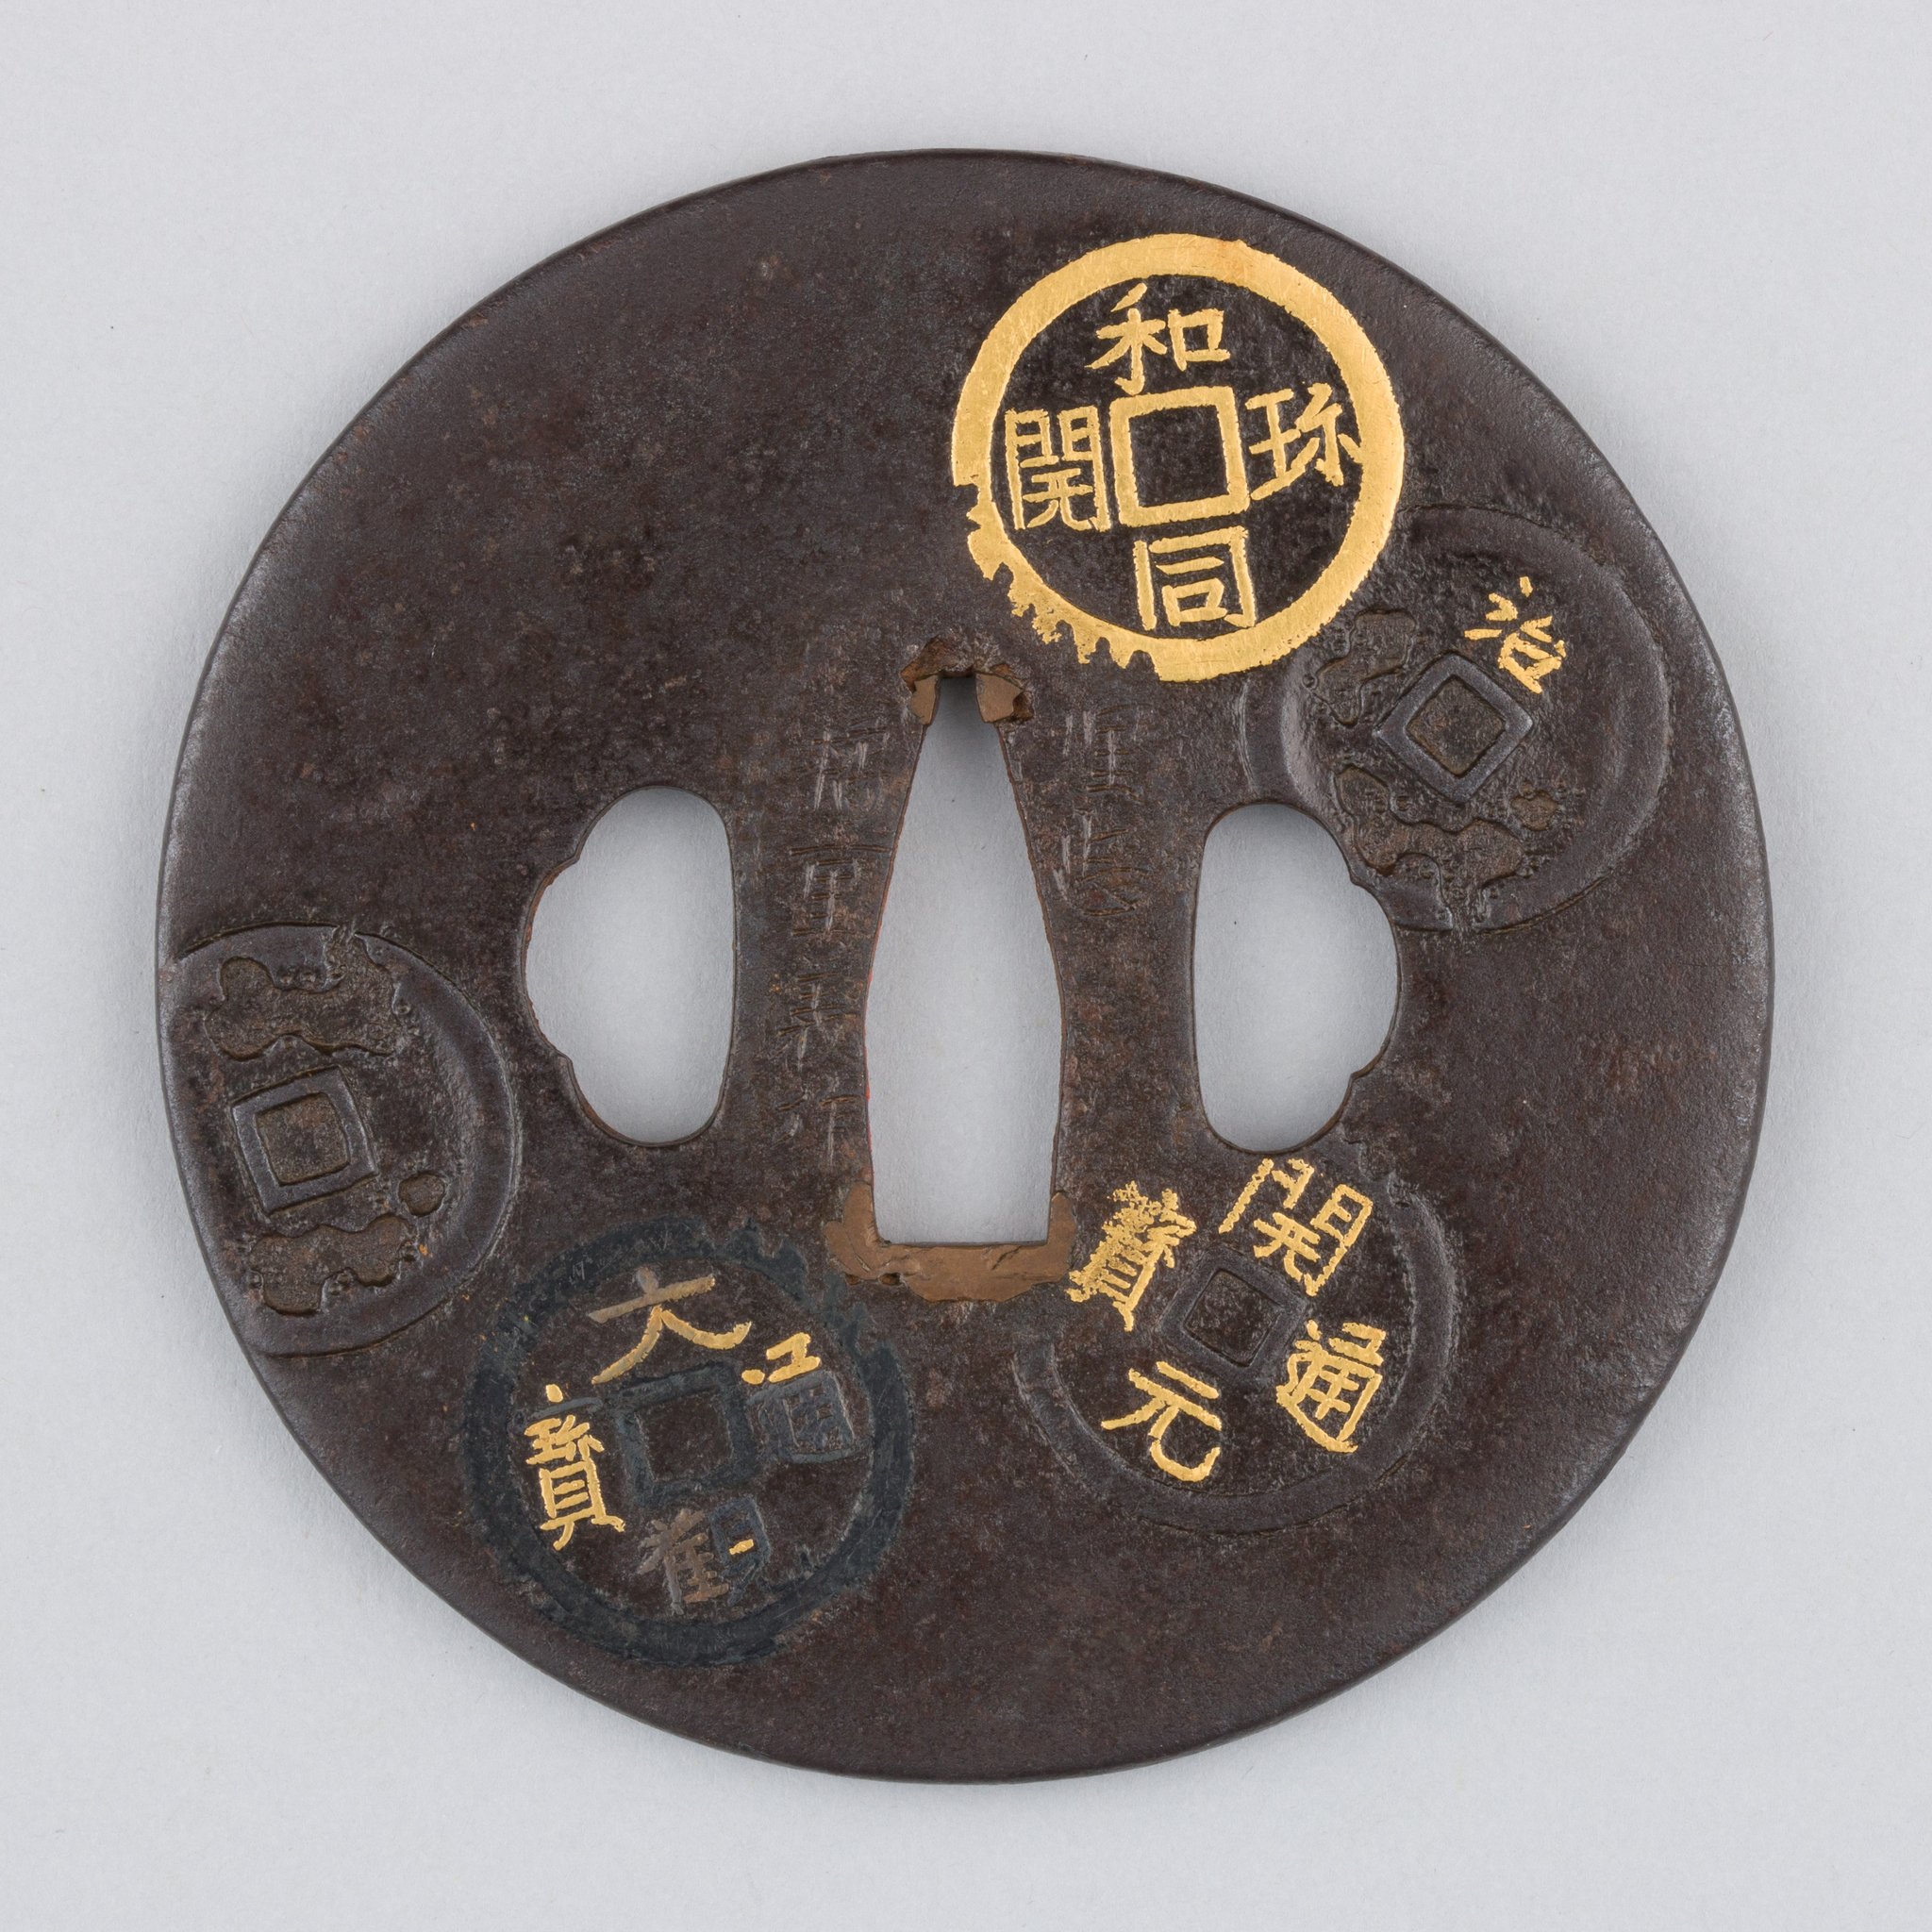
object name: sword guard tsuba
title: Sword Guard (Tsuba)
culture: japanese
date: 1601-1700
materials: copper, gold, iron, silver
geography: japan